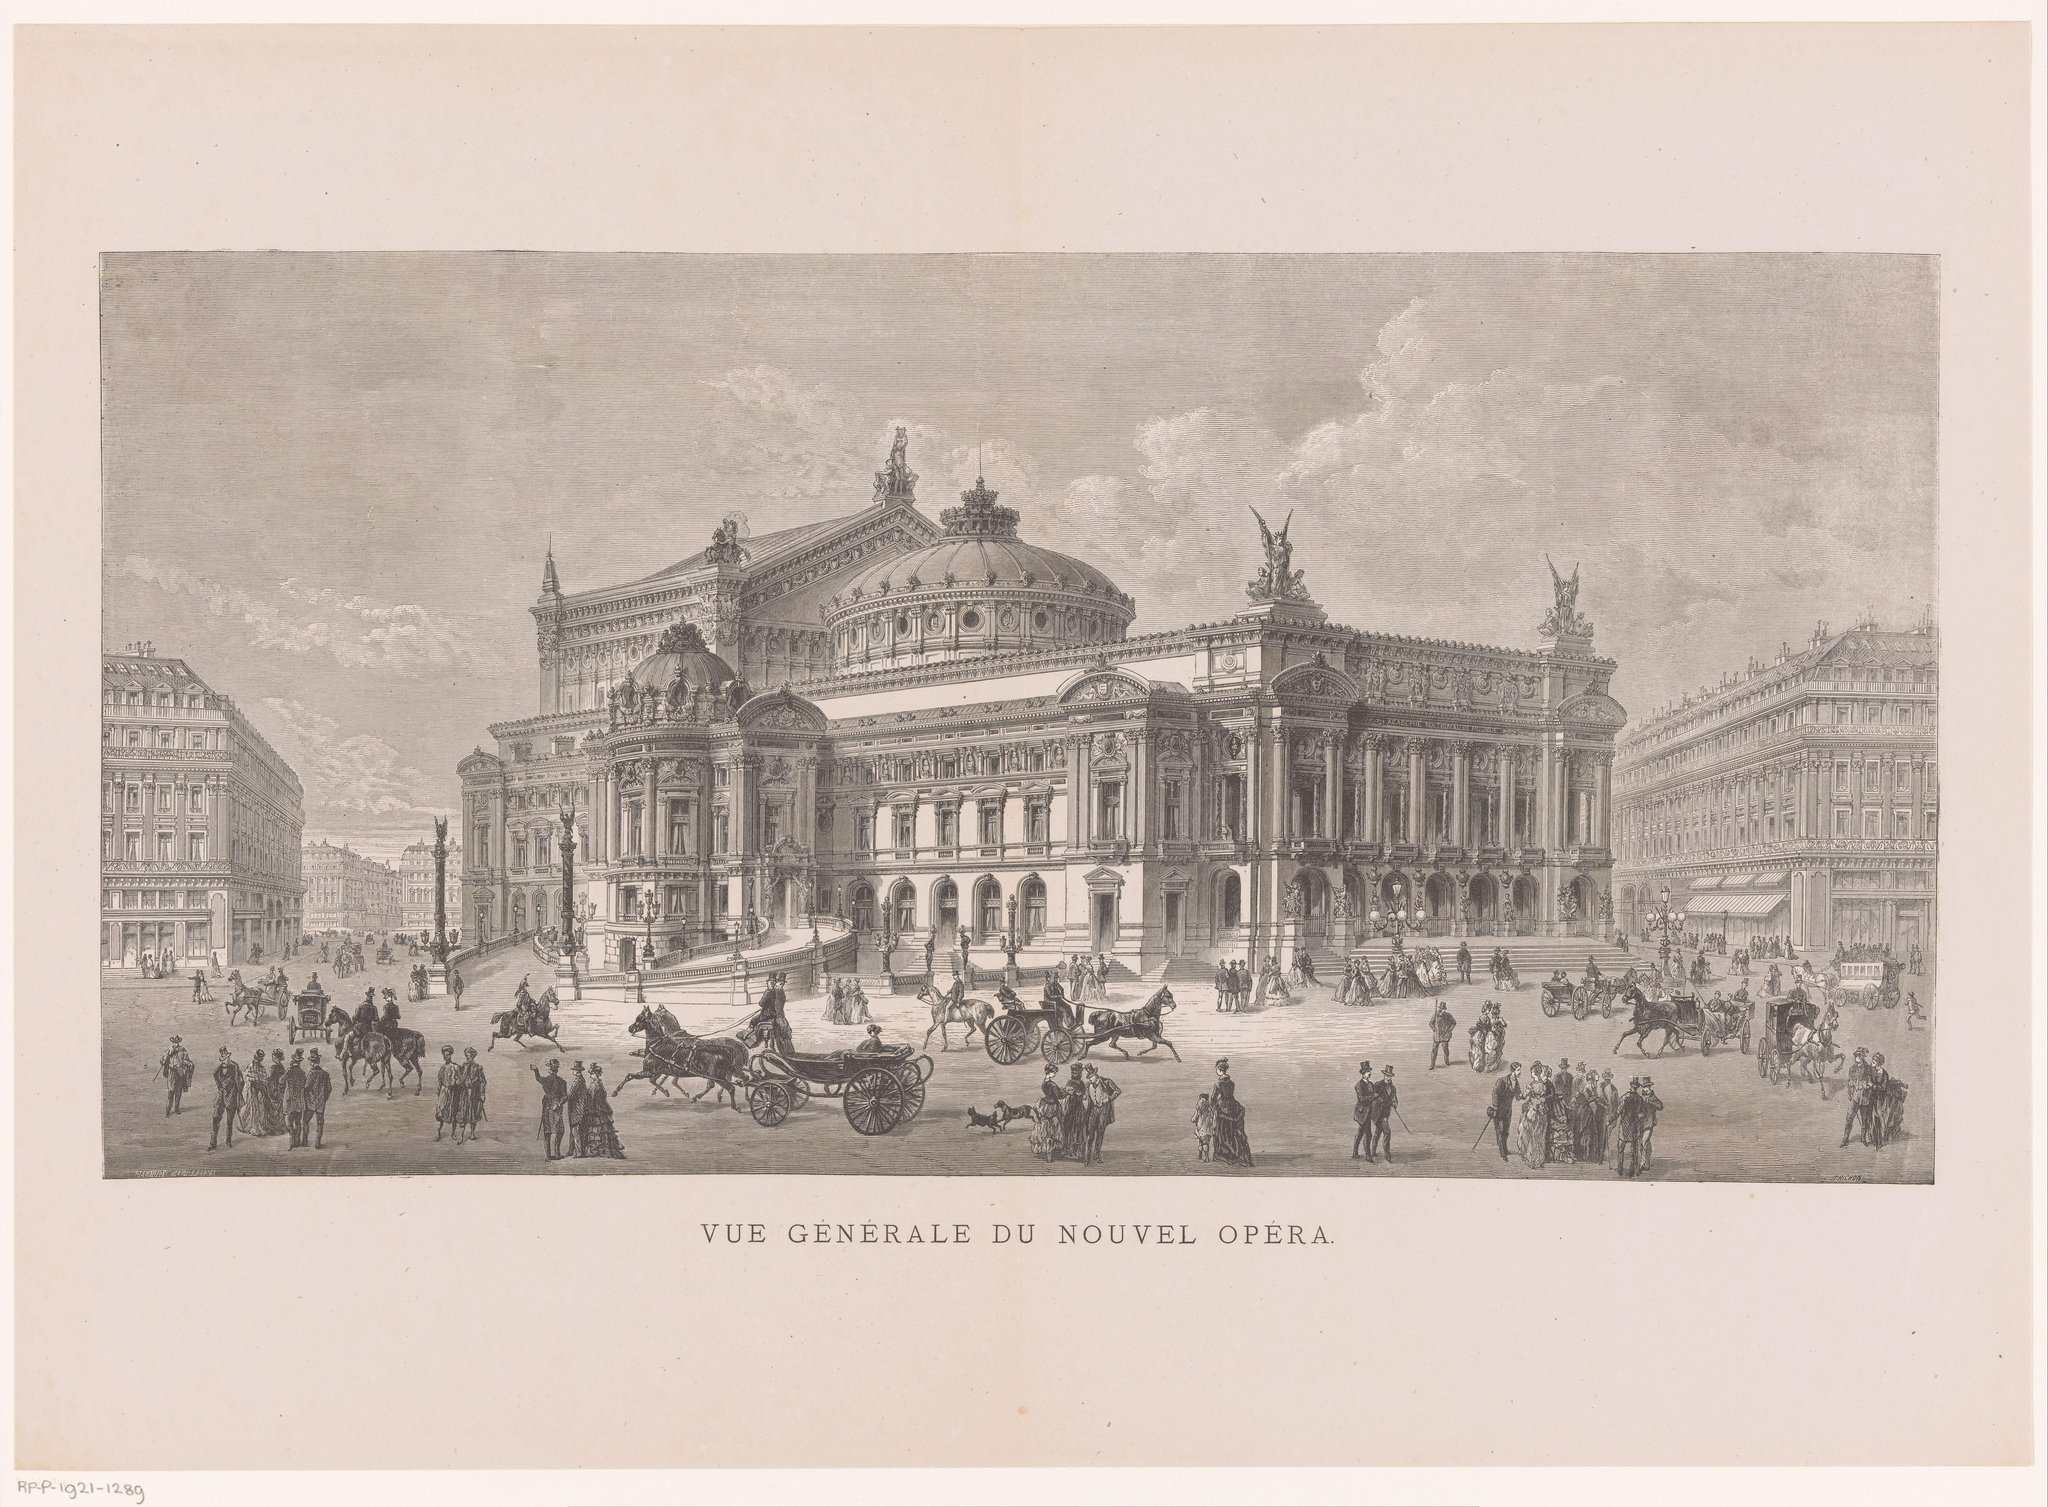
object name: print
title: Gezicht op de Opéra Garnier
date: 1824-1898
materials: paper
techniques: engraving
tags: city-view, and landscape with man-made constructions (+ city(-scape) with figures, staffage), opera house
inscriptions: collector's mark: Lugt 2233